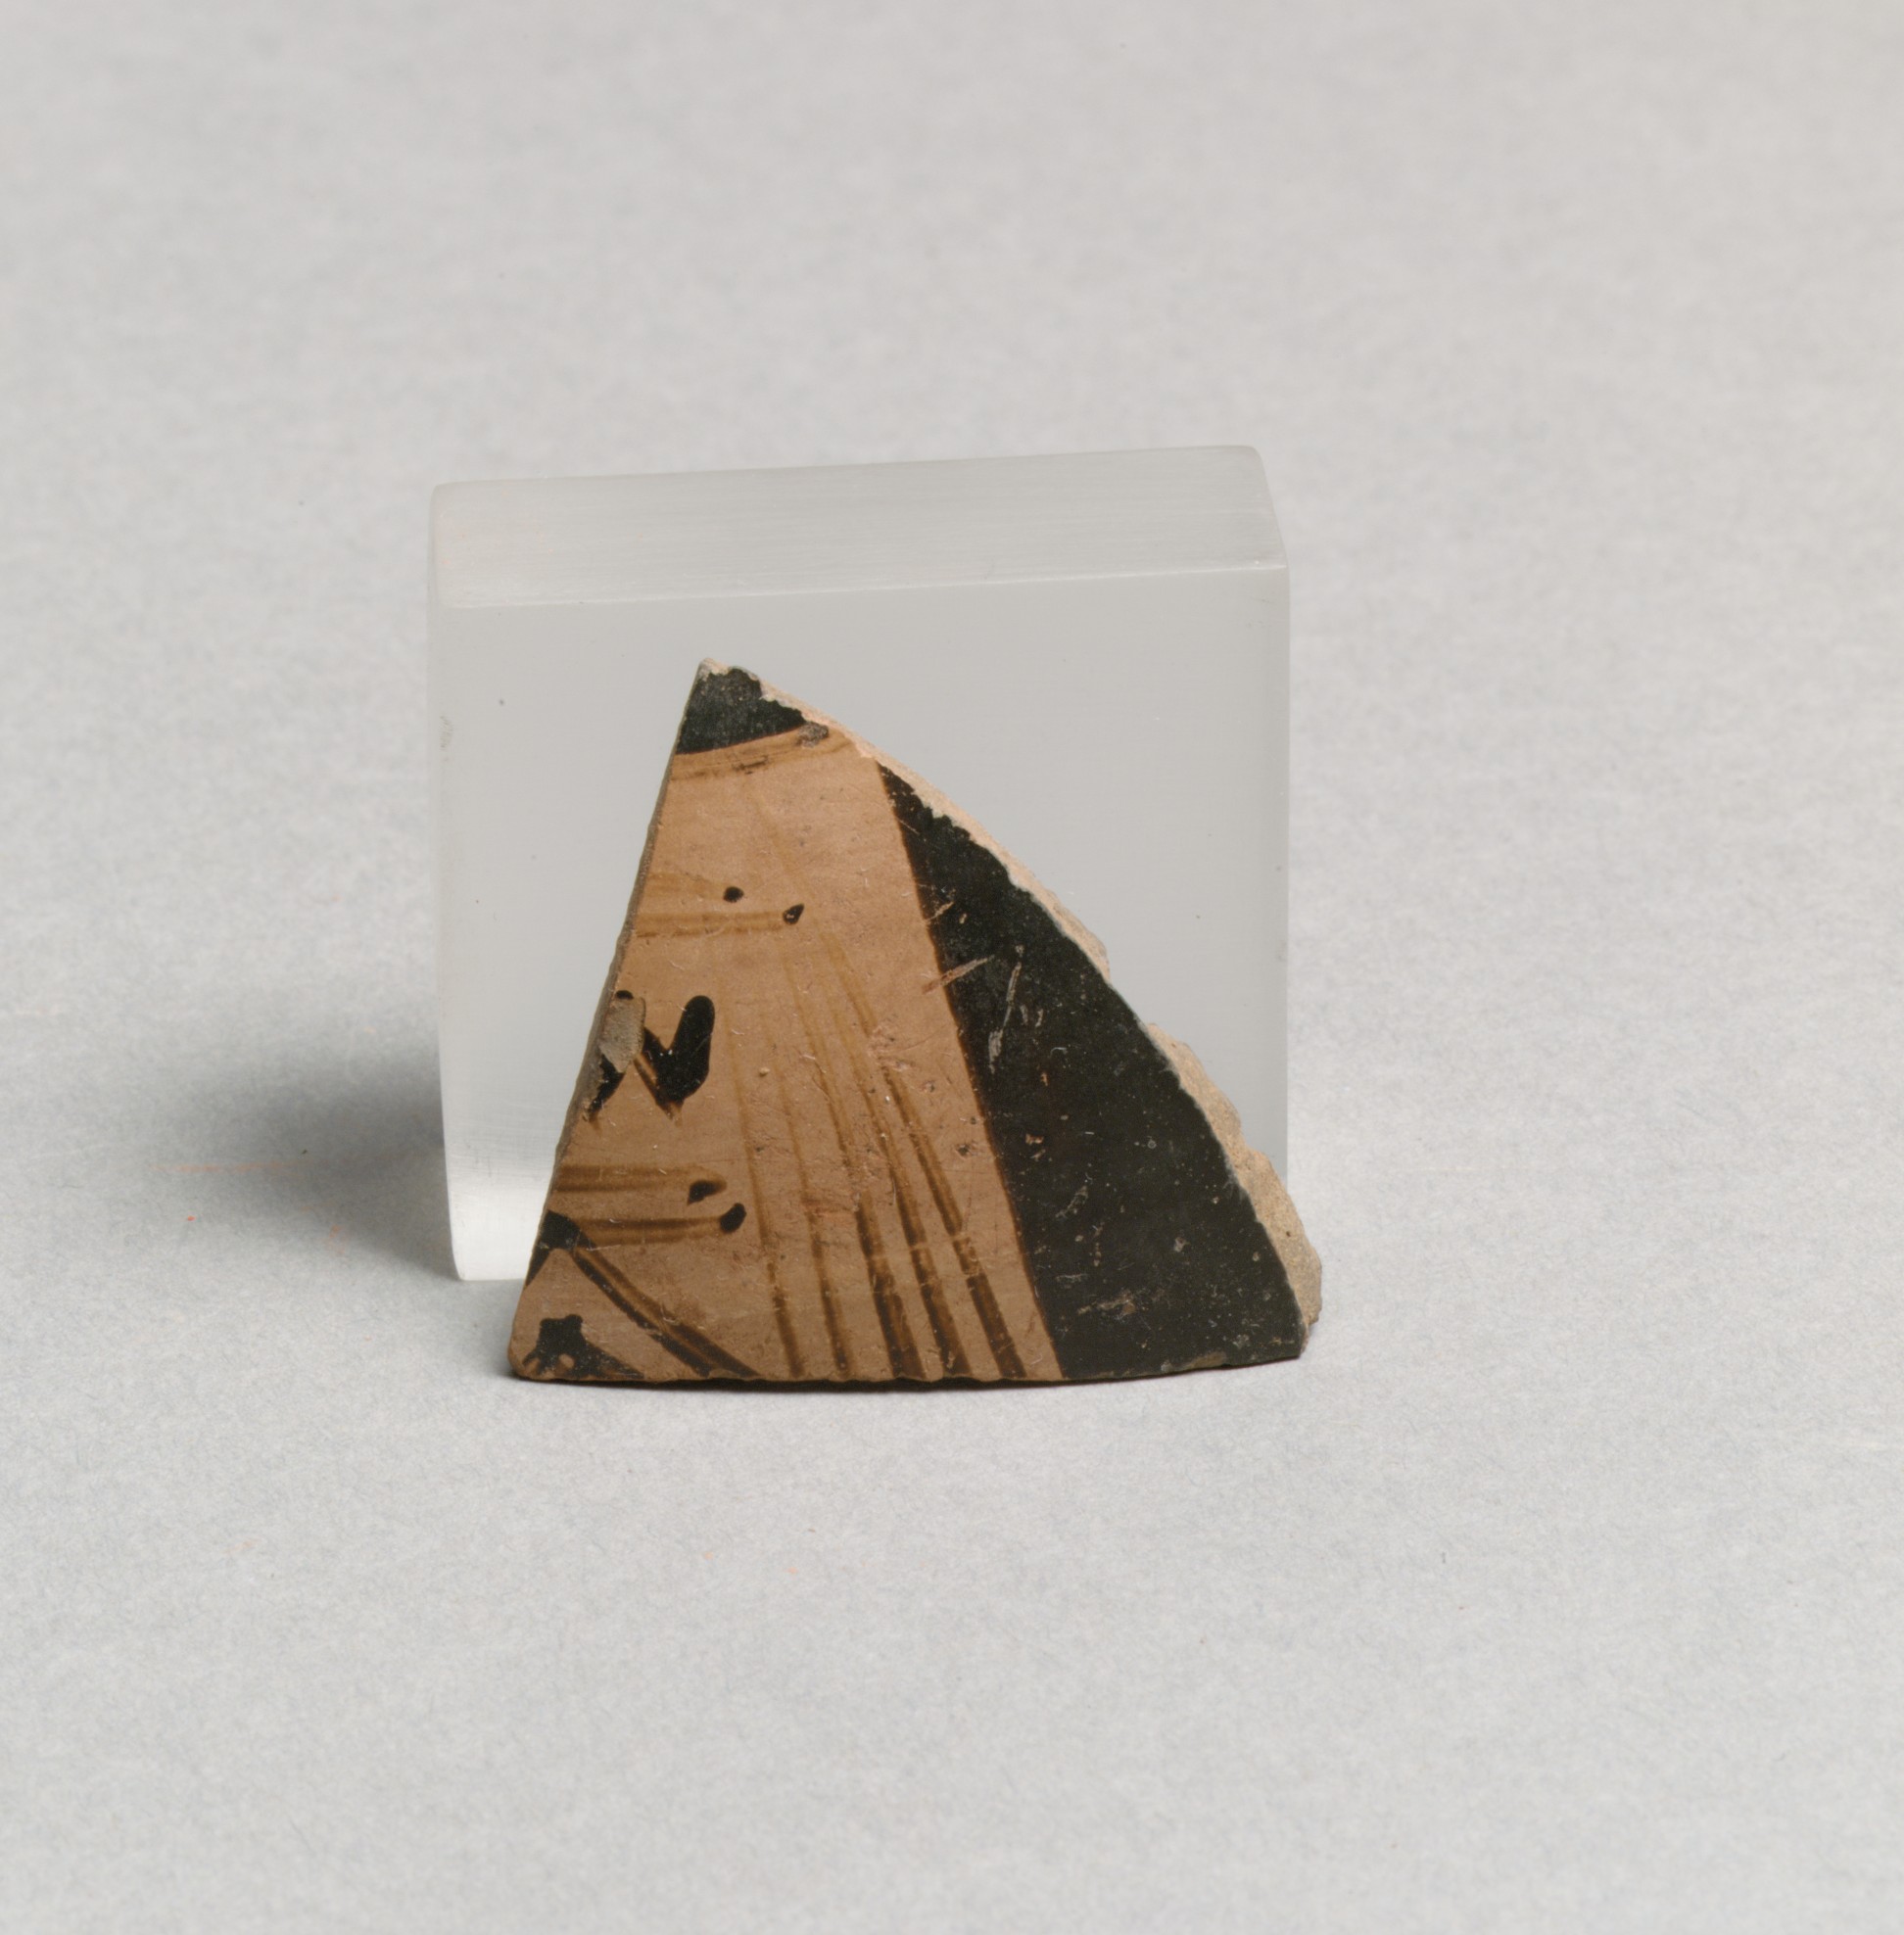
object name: vase fragment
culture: greek or lydian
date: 900-30 BCE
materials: terracotta